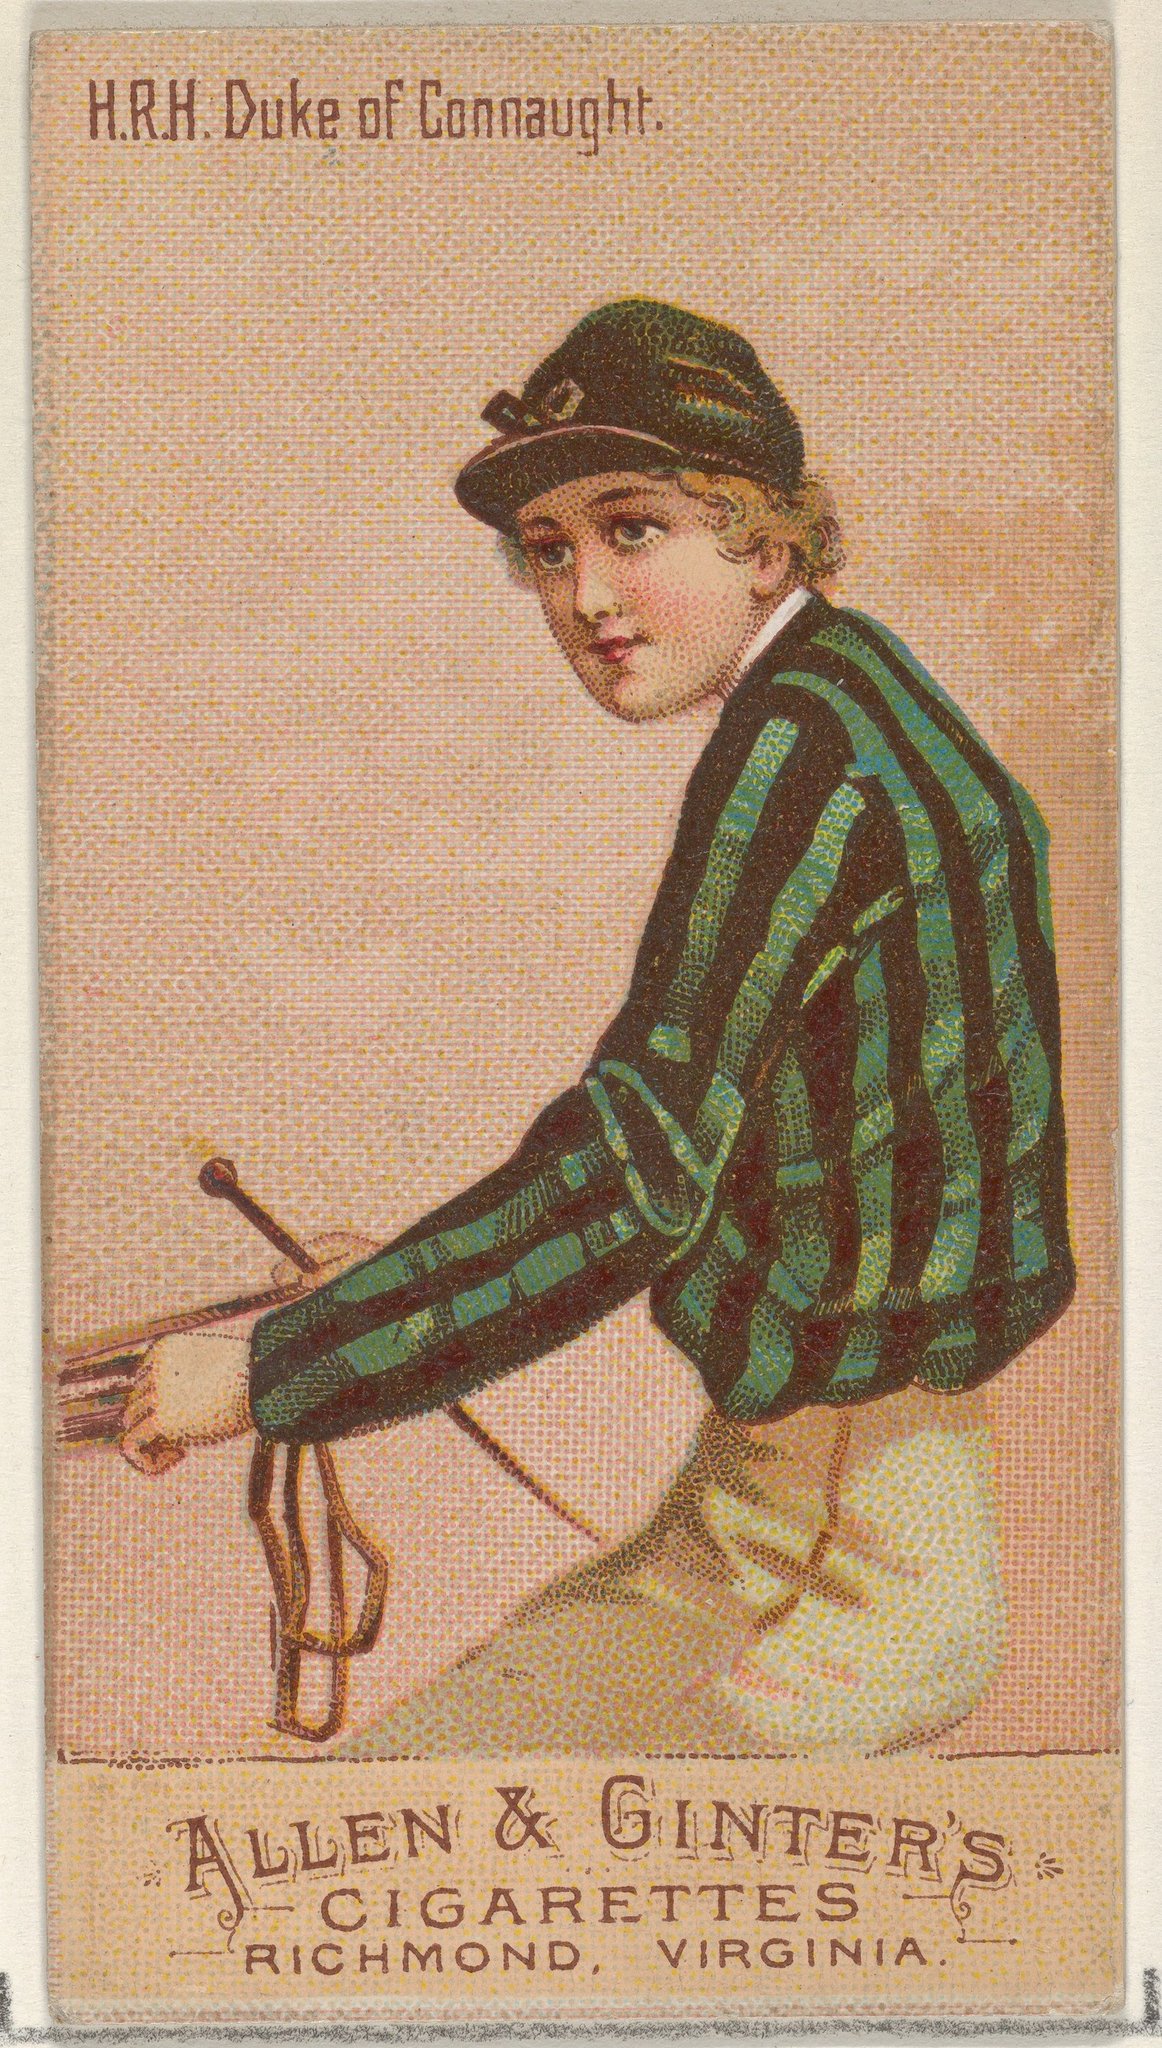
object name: print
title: H.R.H. Duke of Connaught, from the Racing Colors of the World series (N22b) for Allen & Ginter Cigarettes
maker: allen & ginter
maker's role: publisher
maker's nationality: american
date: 1888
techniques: color lithograph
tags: men,jockeys